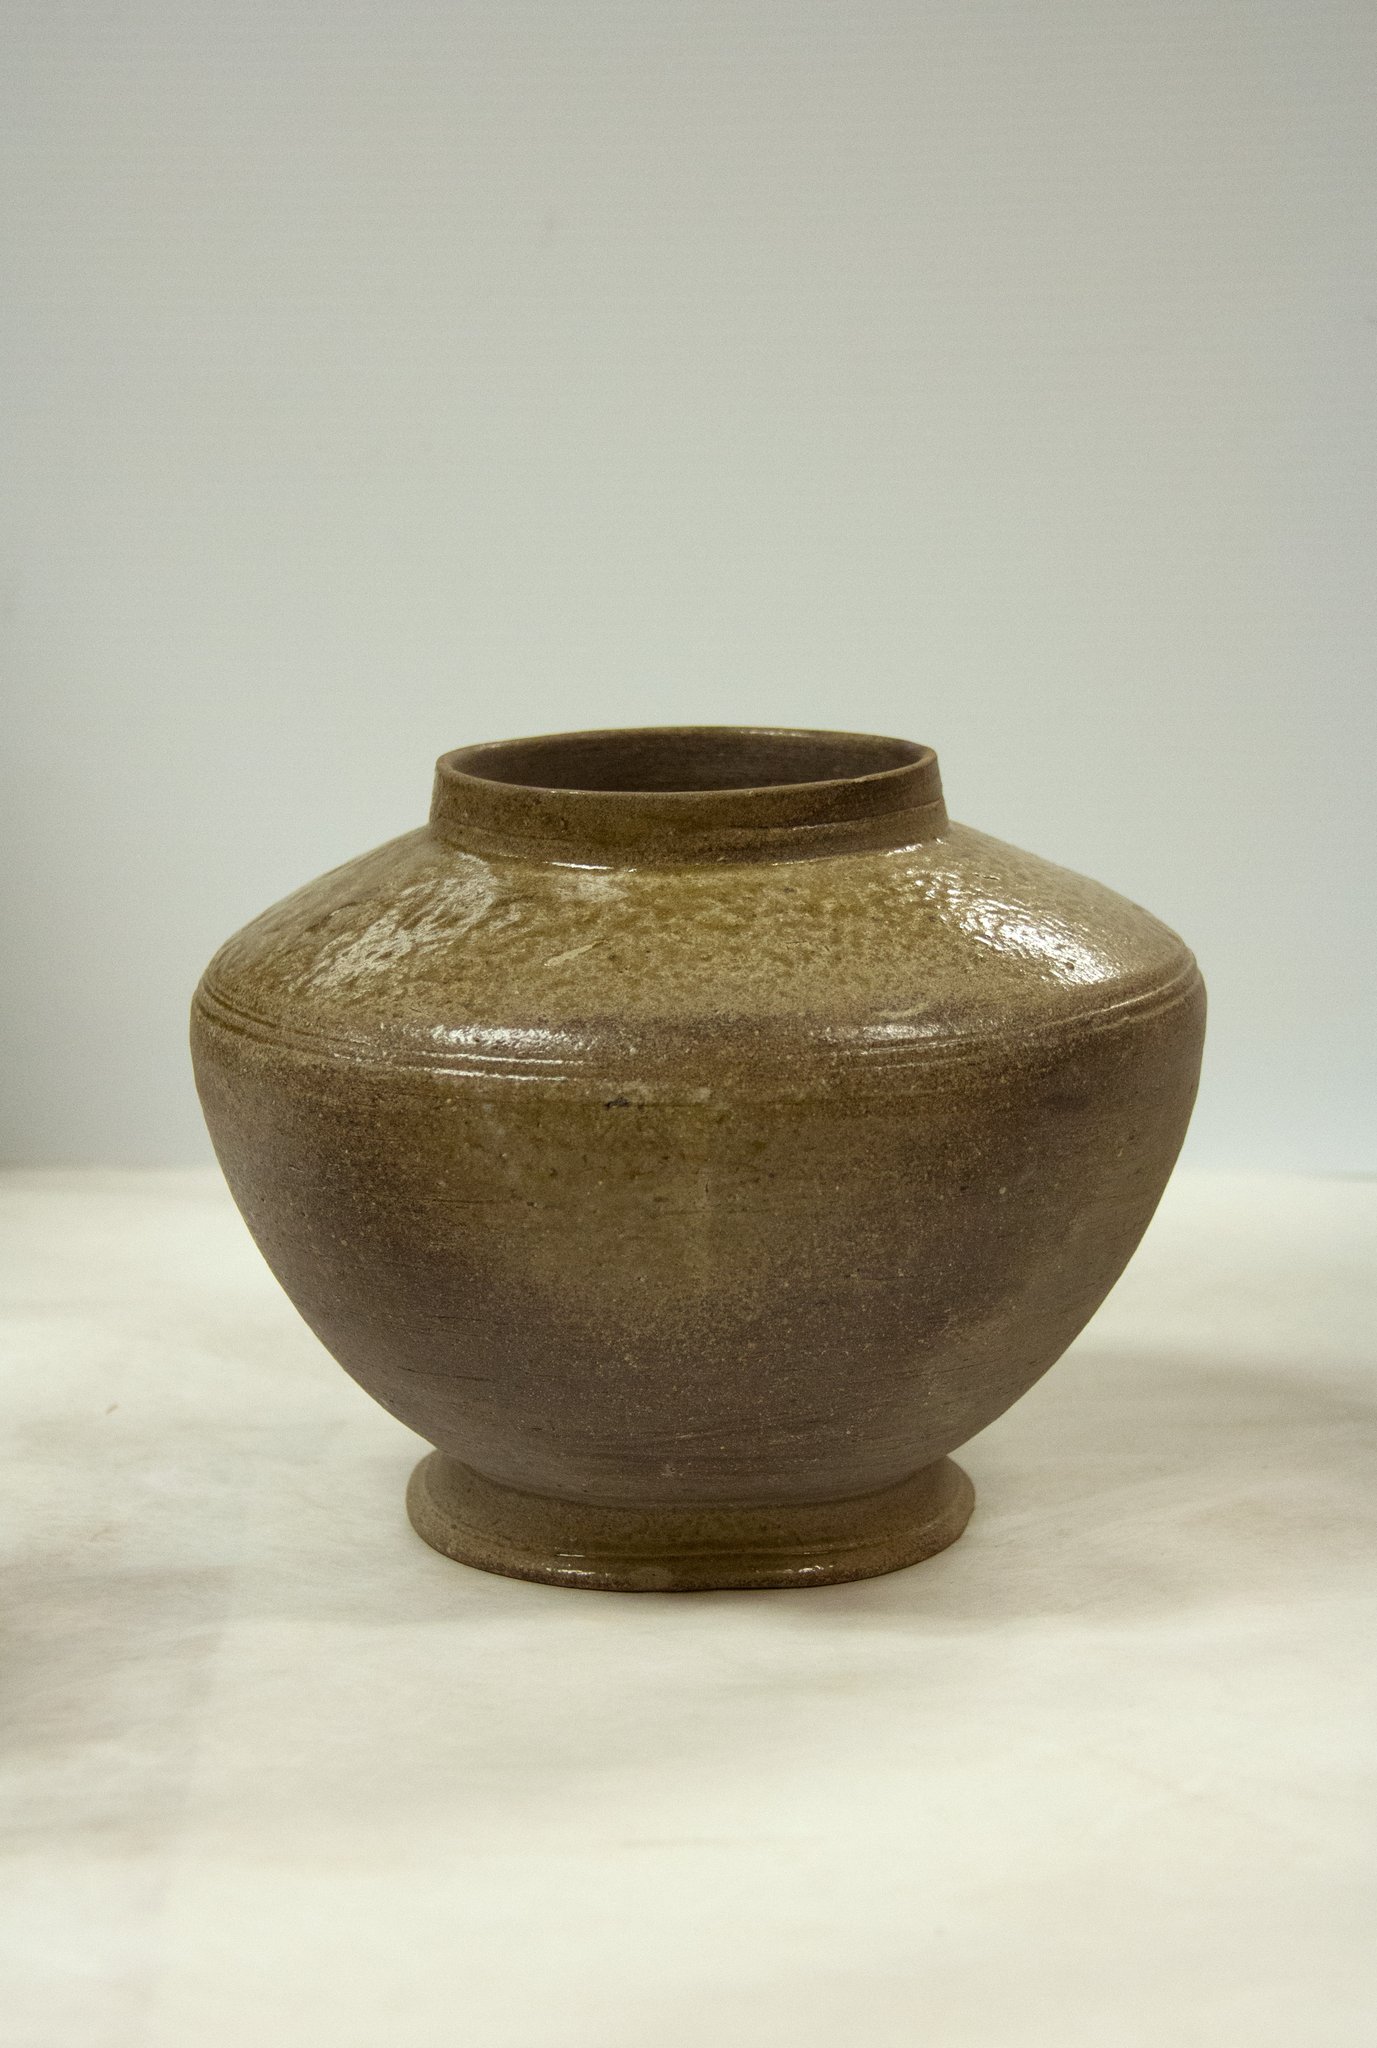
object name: jar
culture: japanese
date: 801-900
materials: wood, glaze, stoneware